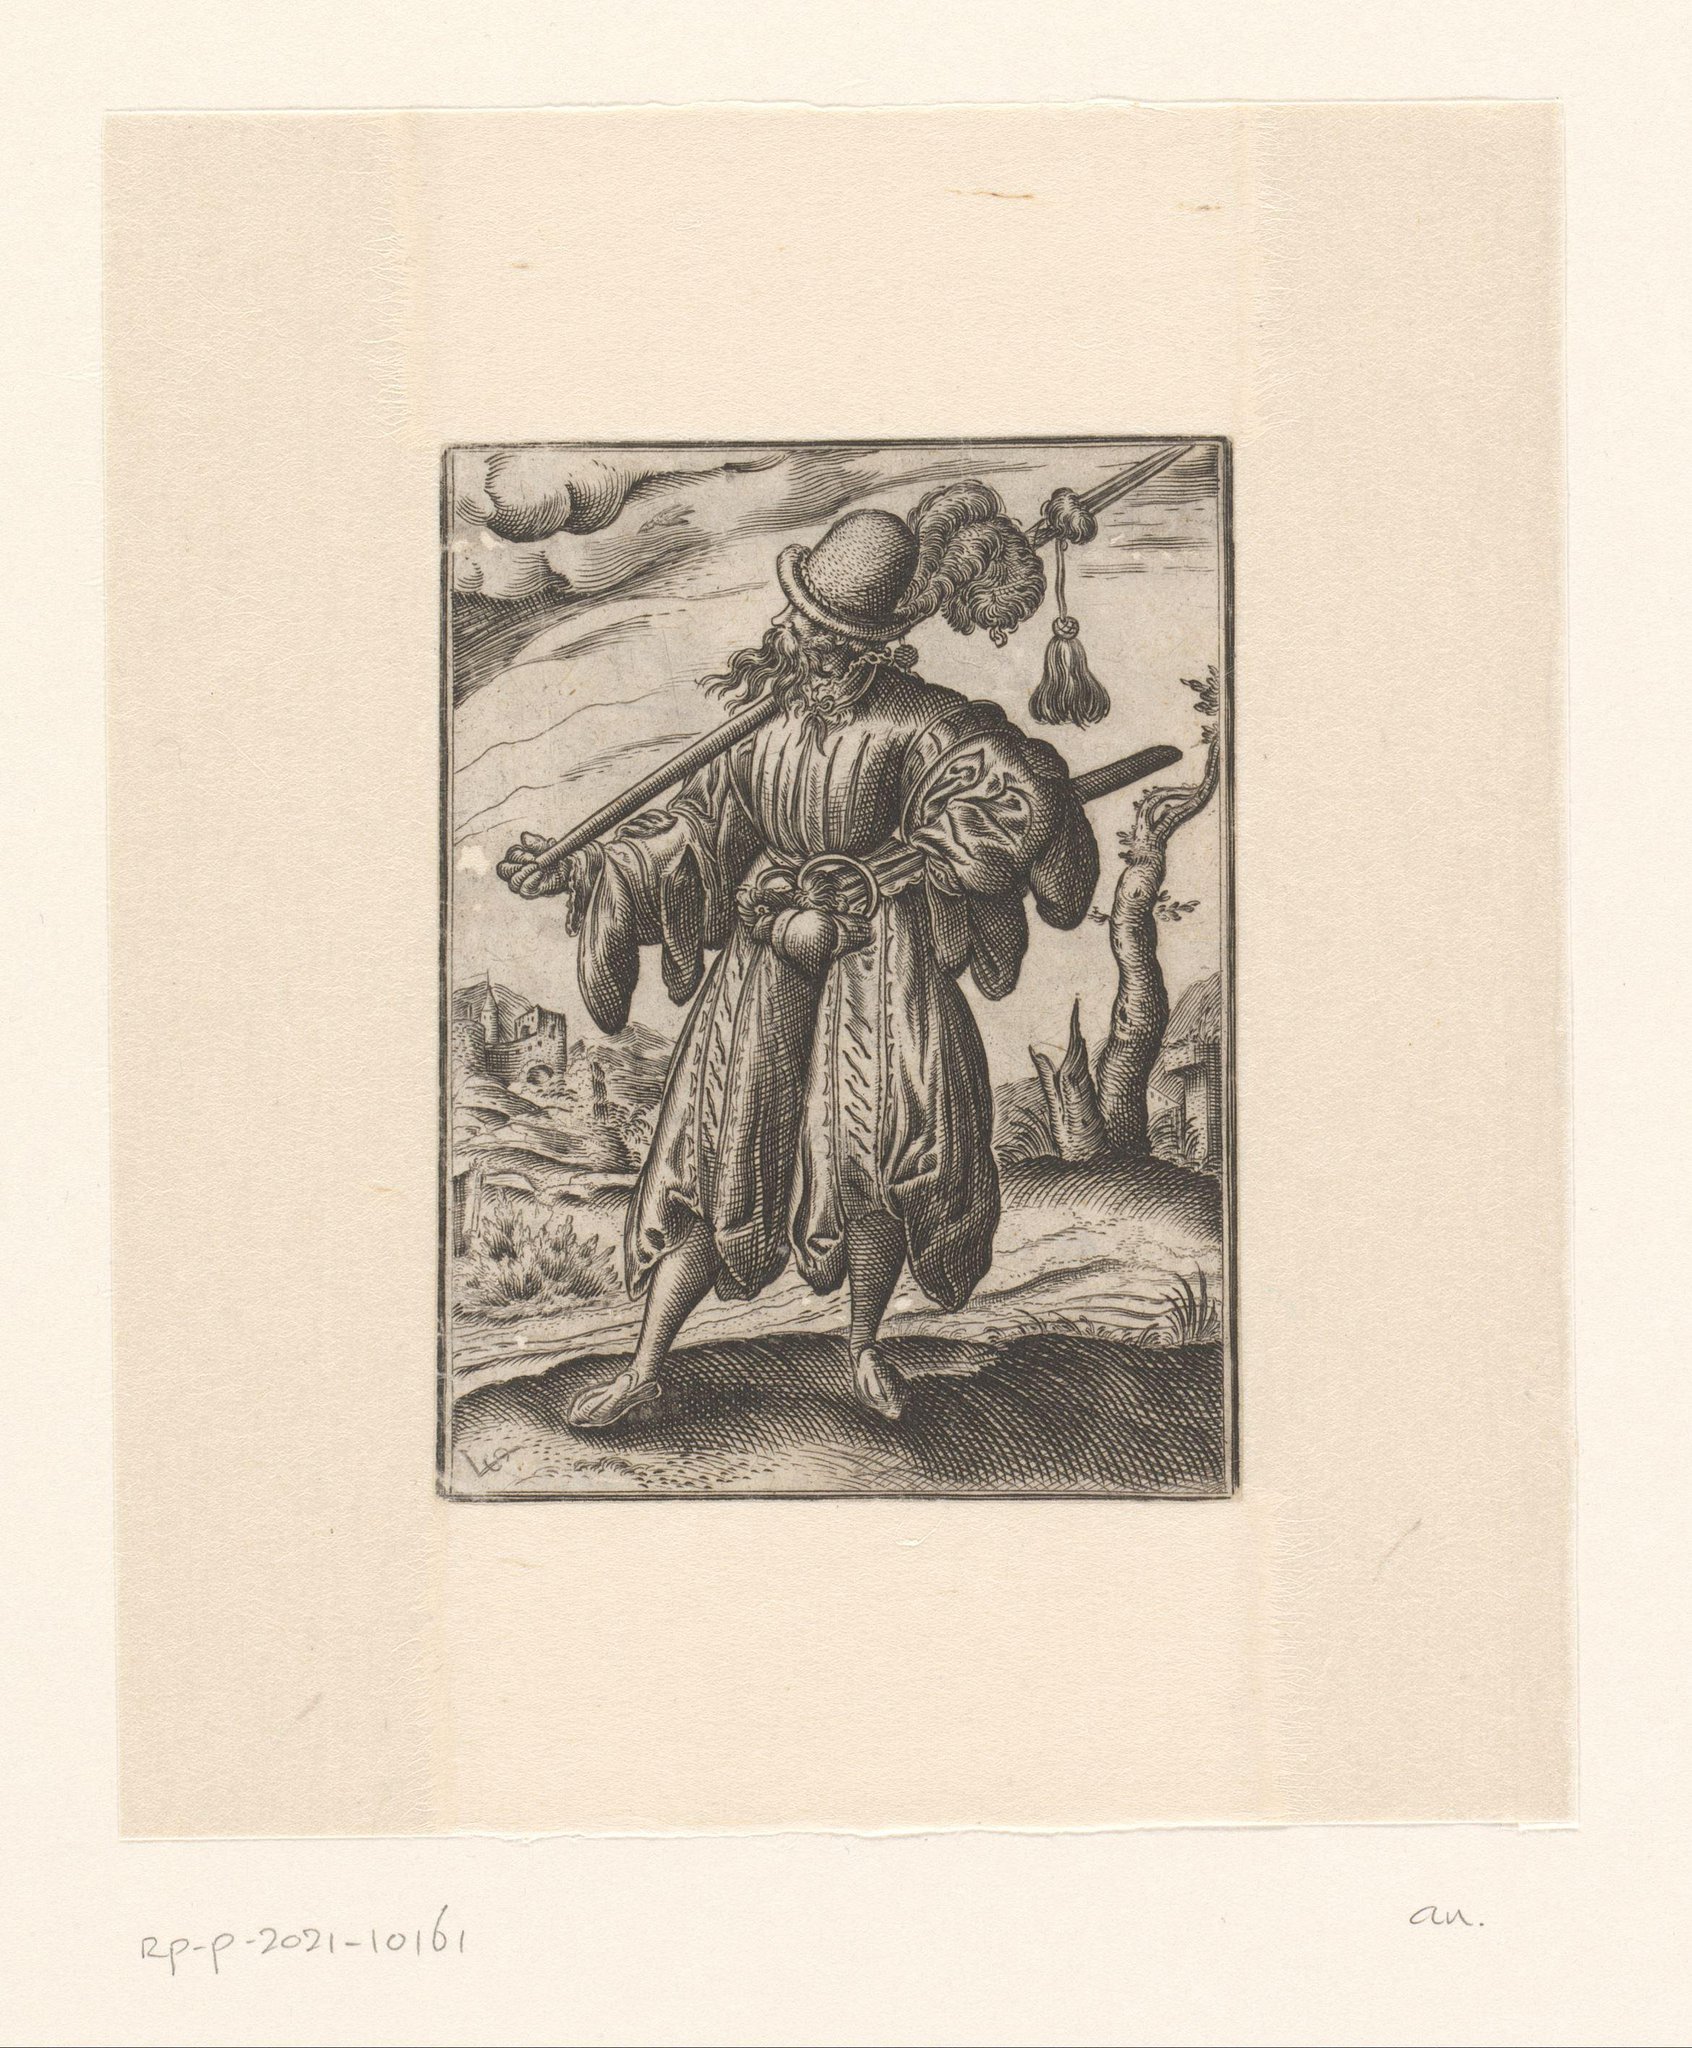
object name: print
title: Landsknecht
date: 1524-1612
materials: paper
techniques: engraving, etching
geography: nuremberg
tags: ranks in the army, landscape with tower or castle, the soldier; the soldier's life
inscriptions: collector's mark: Lugt 2228, inscription: ‘21,2 - 146,a.’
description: Maakt deel uit van een serie van elf prenten met voorstellingen van militaire figuren.